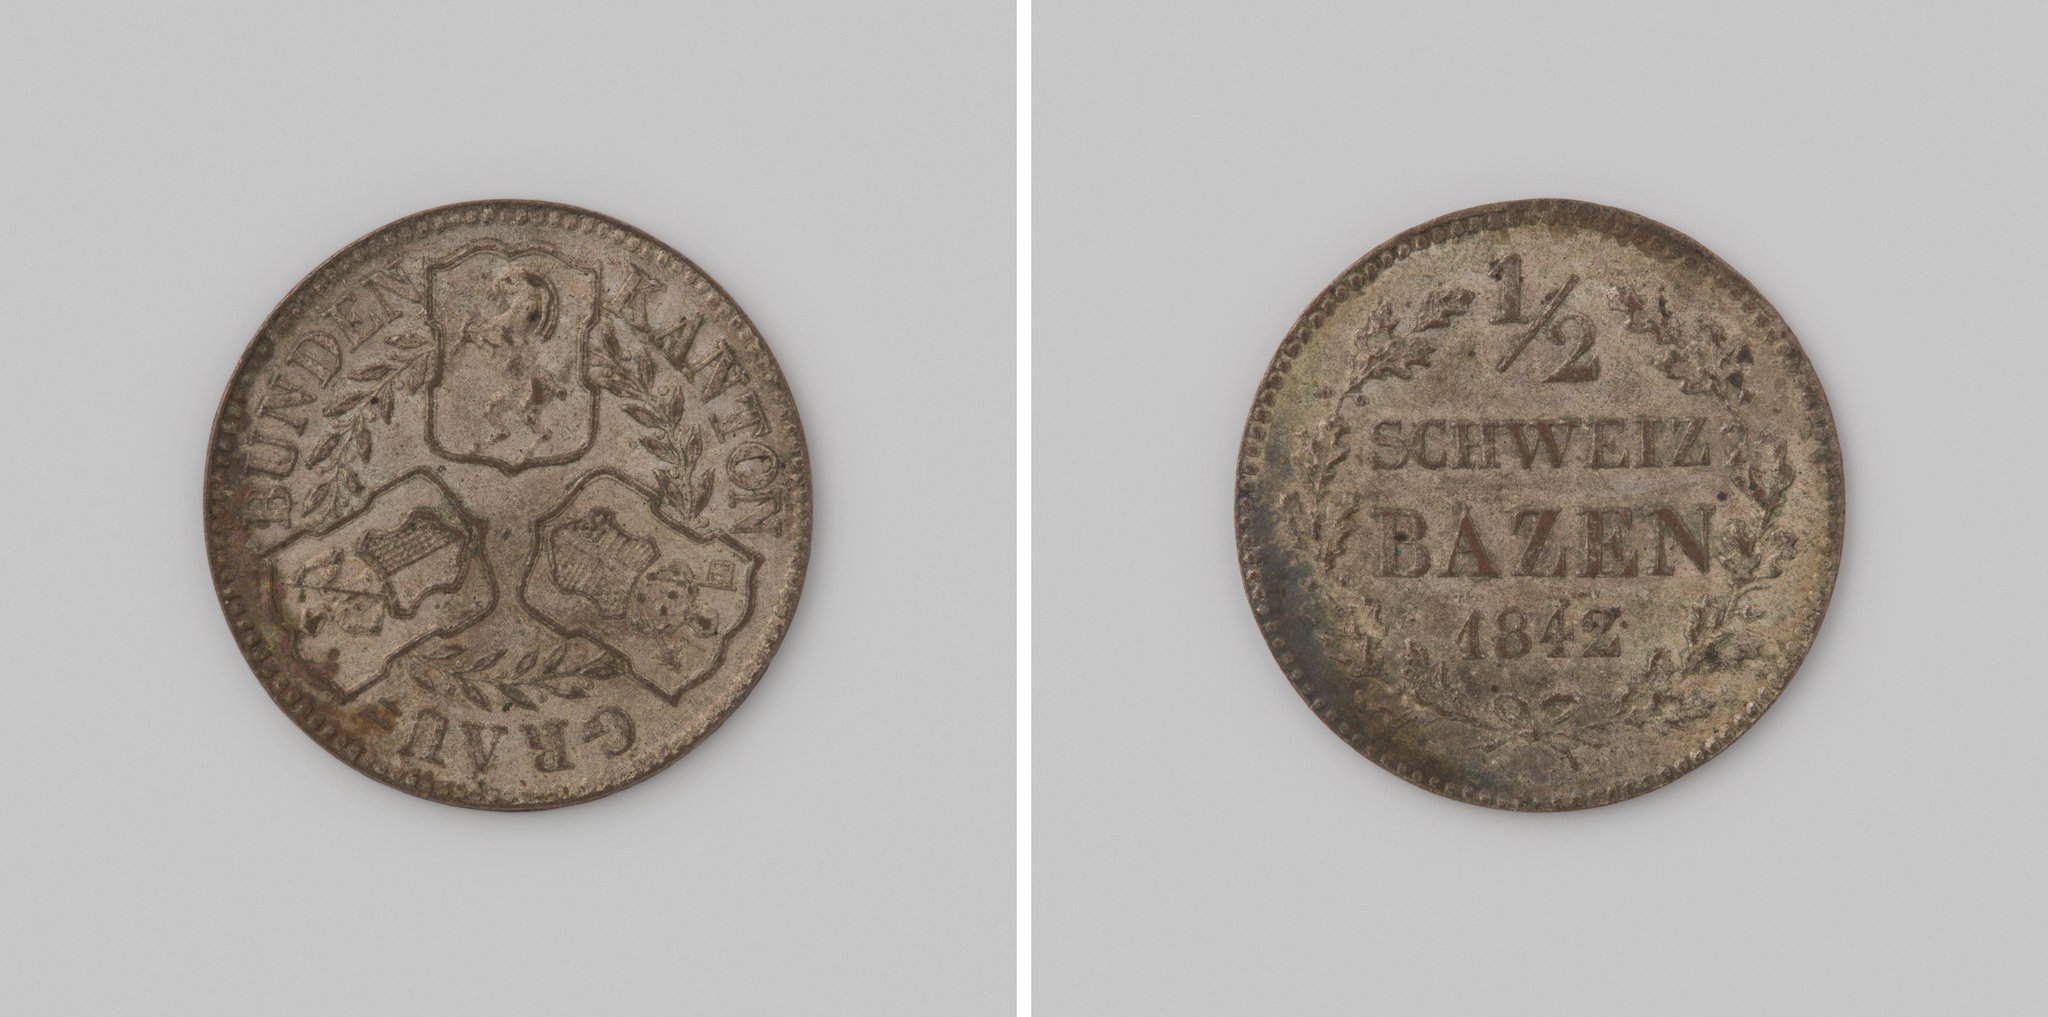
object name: coin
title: ½ Schweizbatzen uit het kanton Graubunden,1842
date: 1842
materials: silver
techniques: striking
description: Zilveren munt. Voorzijde: op een krans van bladeren drie wapenschilden. Keerzijde: binnen twee samengebonden takken in drie regels waarde-aanduiding, waaronder jaartal. Gladde rand.